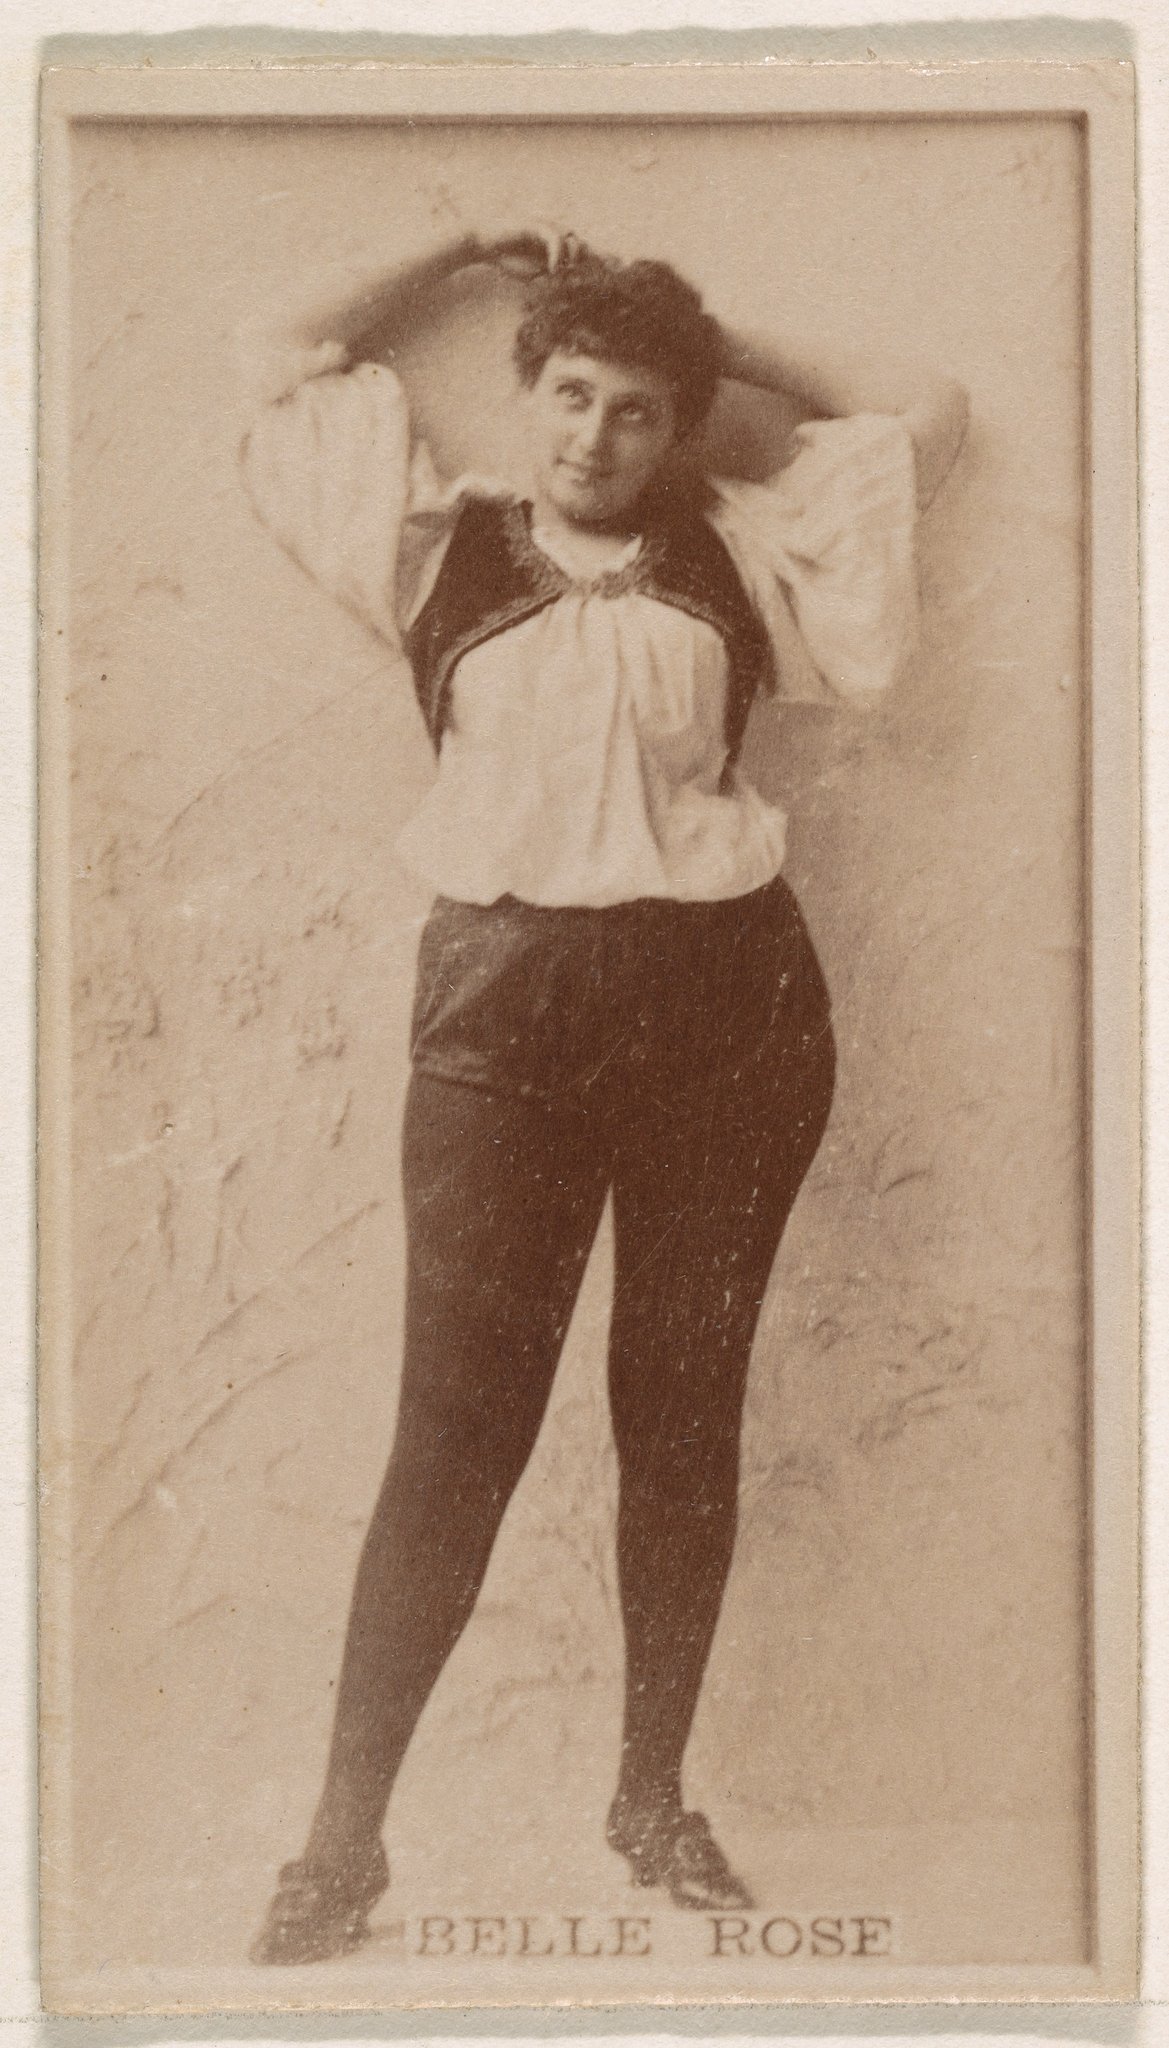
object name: photograph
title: Belle Rose, from the Actresses series (N245) issued by Kinney Brothers to promote Sweet Caporal Cigarettes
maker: kinney brothers tobacco company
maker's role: publisher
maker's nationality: american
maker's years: 1869-2011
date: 1890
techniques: albumen silver print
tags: portraits,women,actresses